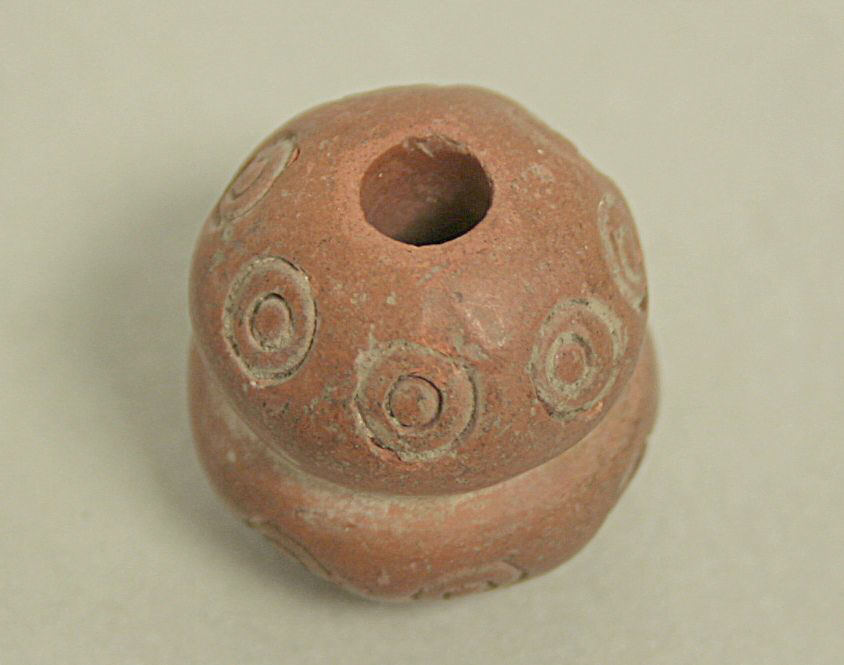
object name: spindle whorl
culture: peruvian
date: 1-500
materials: ceramic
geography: peru